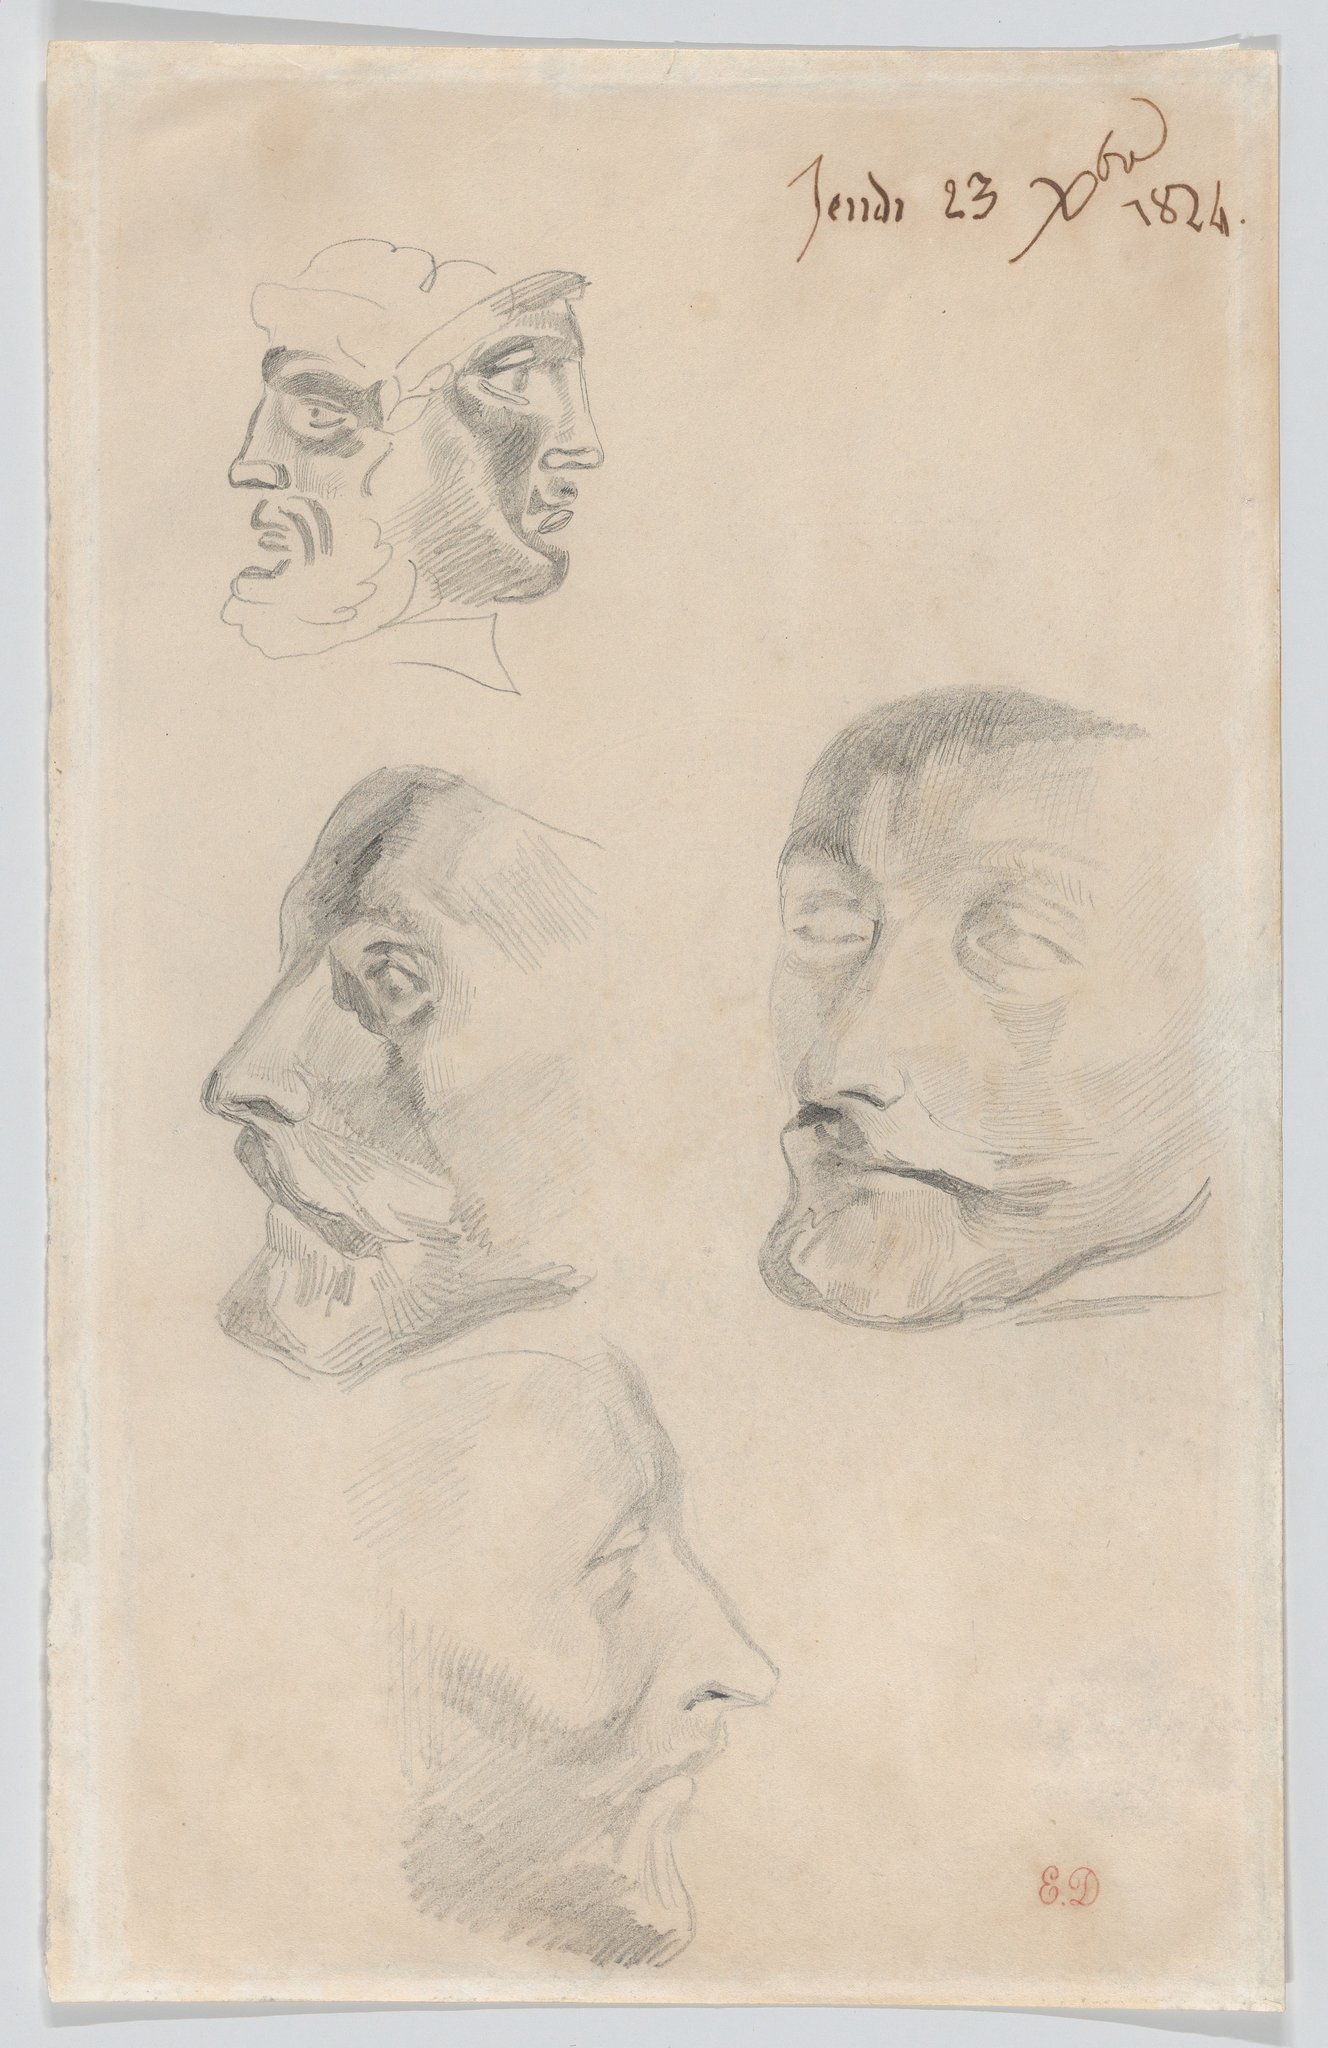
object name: drawing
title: Studies of a Bearded Head and a Greek or Roman Coin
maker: eugène delacroix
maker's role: artist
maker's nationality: french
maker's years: 1798-1863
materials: graphite